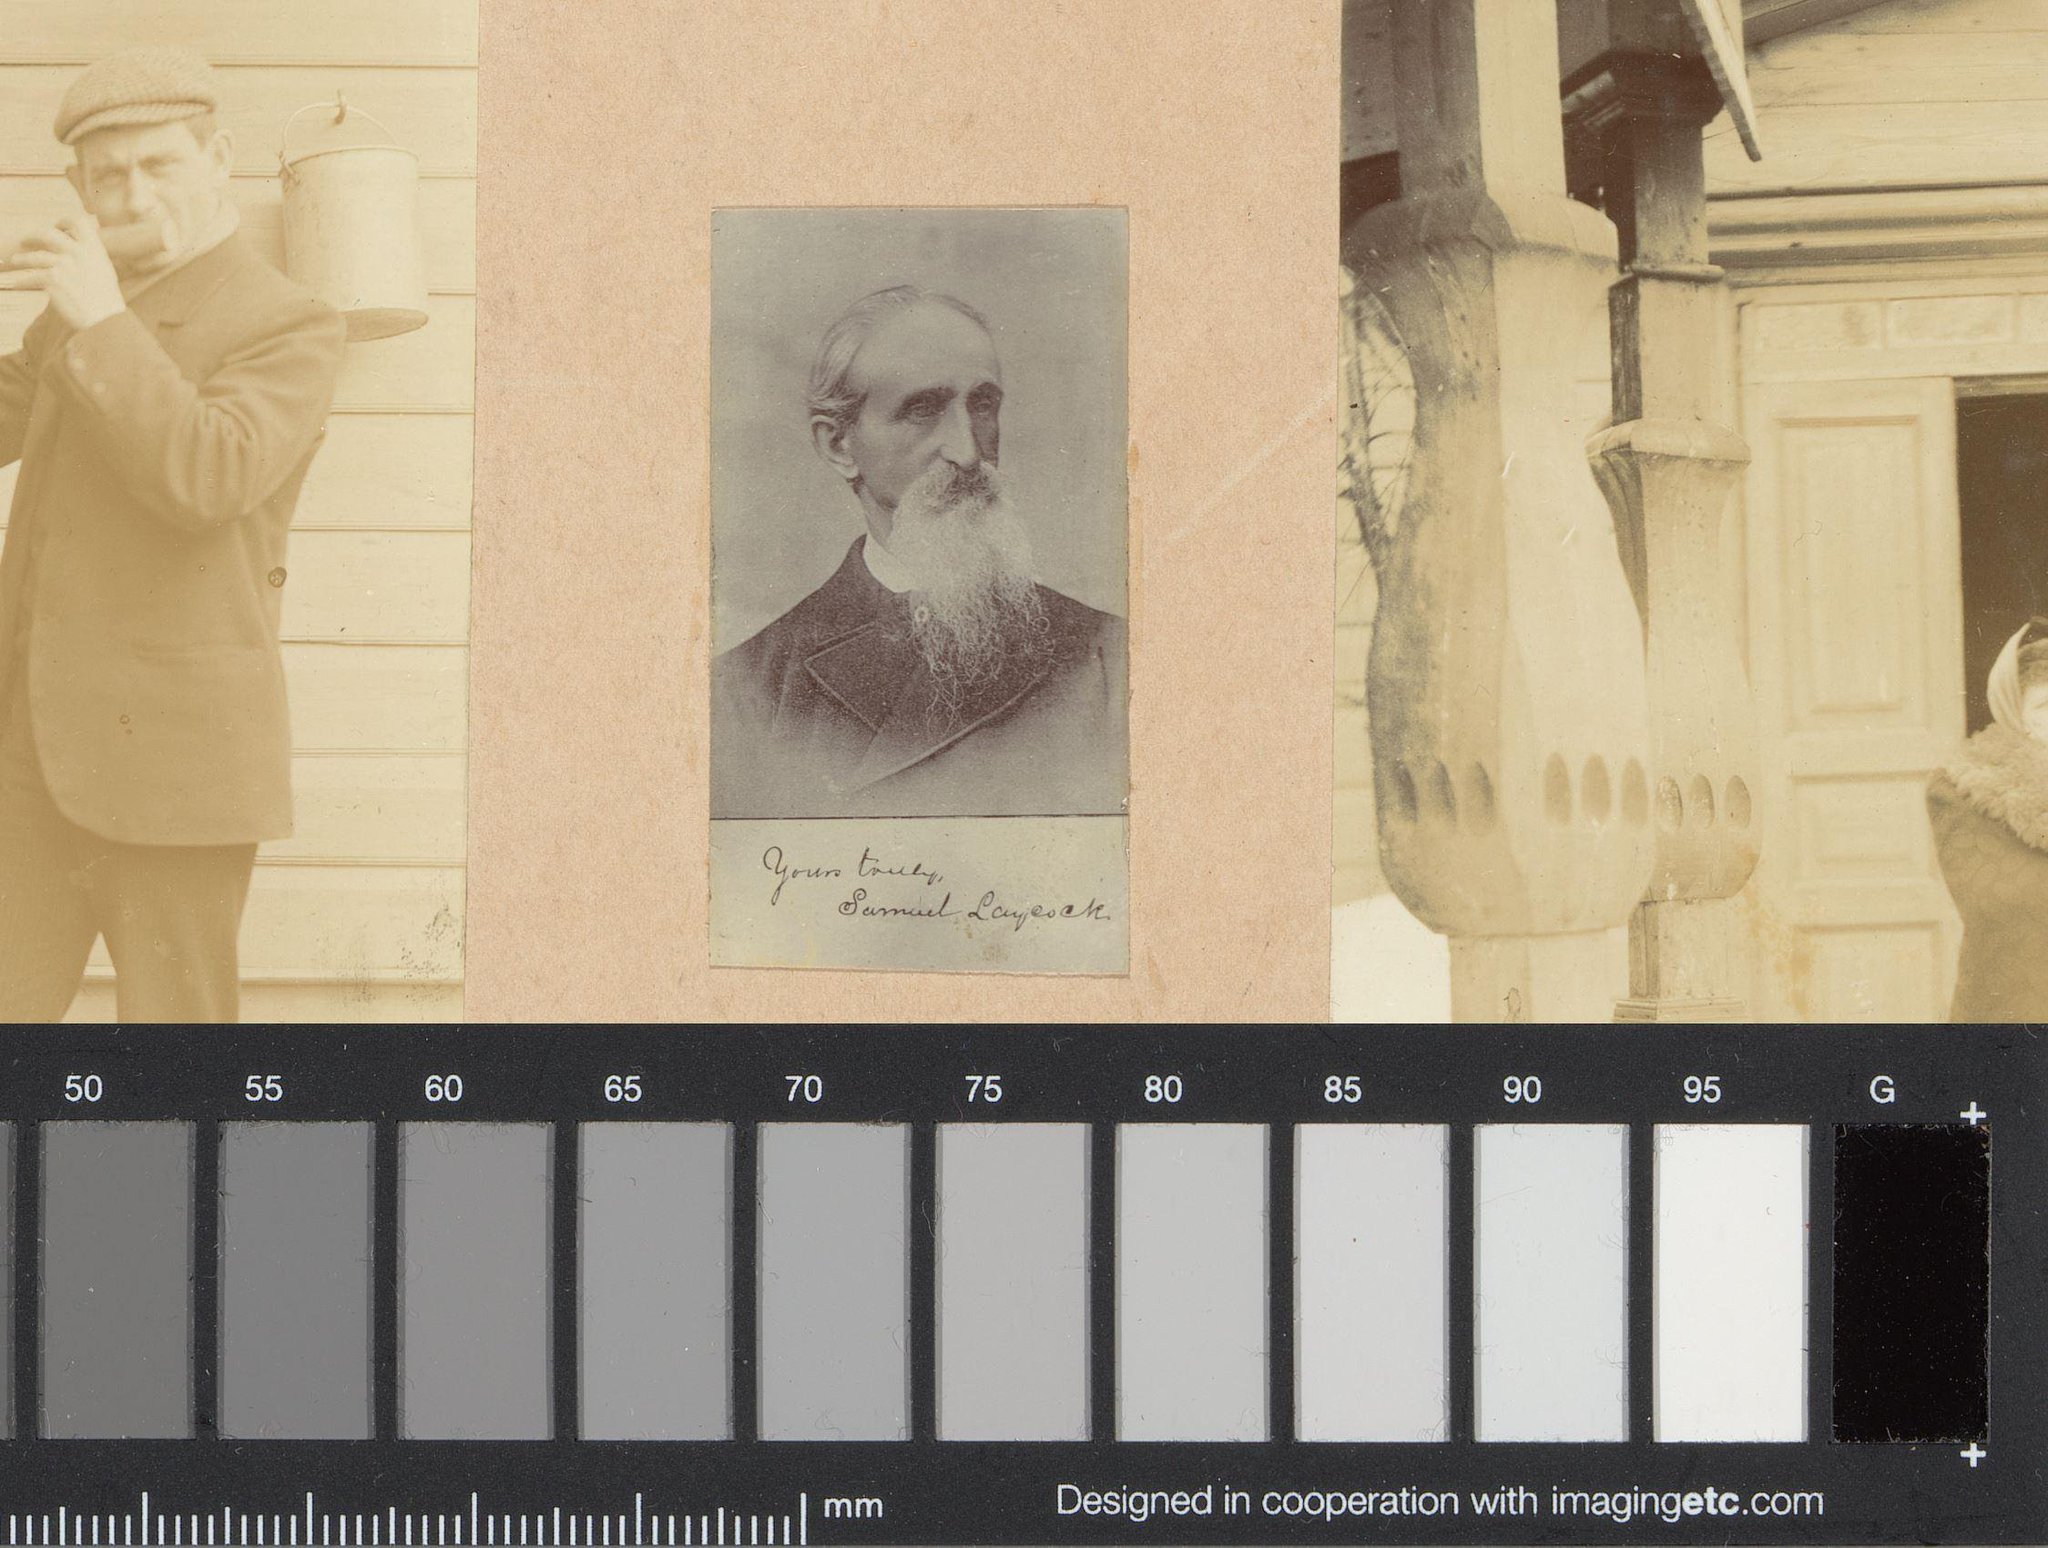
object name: reproduction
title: Fotoreproductie van een foto van Samuel Layes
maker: joseph cheetham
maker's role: engineer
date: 1903-1904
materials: photographic support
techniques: gelatin silver print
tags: adult man, beard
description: Onderdeel van Fotoalbum van de Engelse familie Cheetham met opnames van hun verblijf in Rusland.